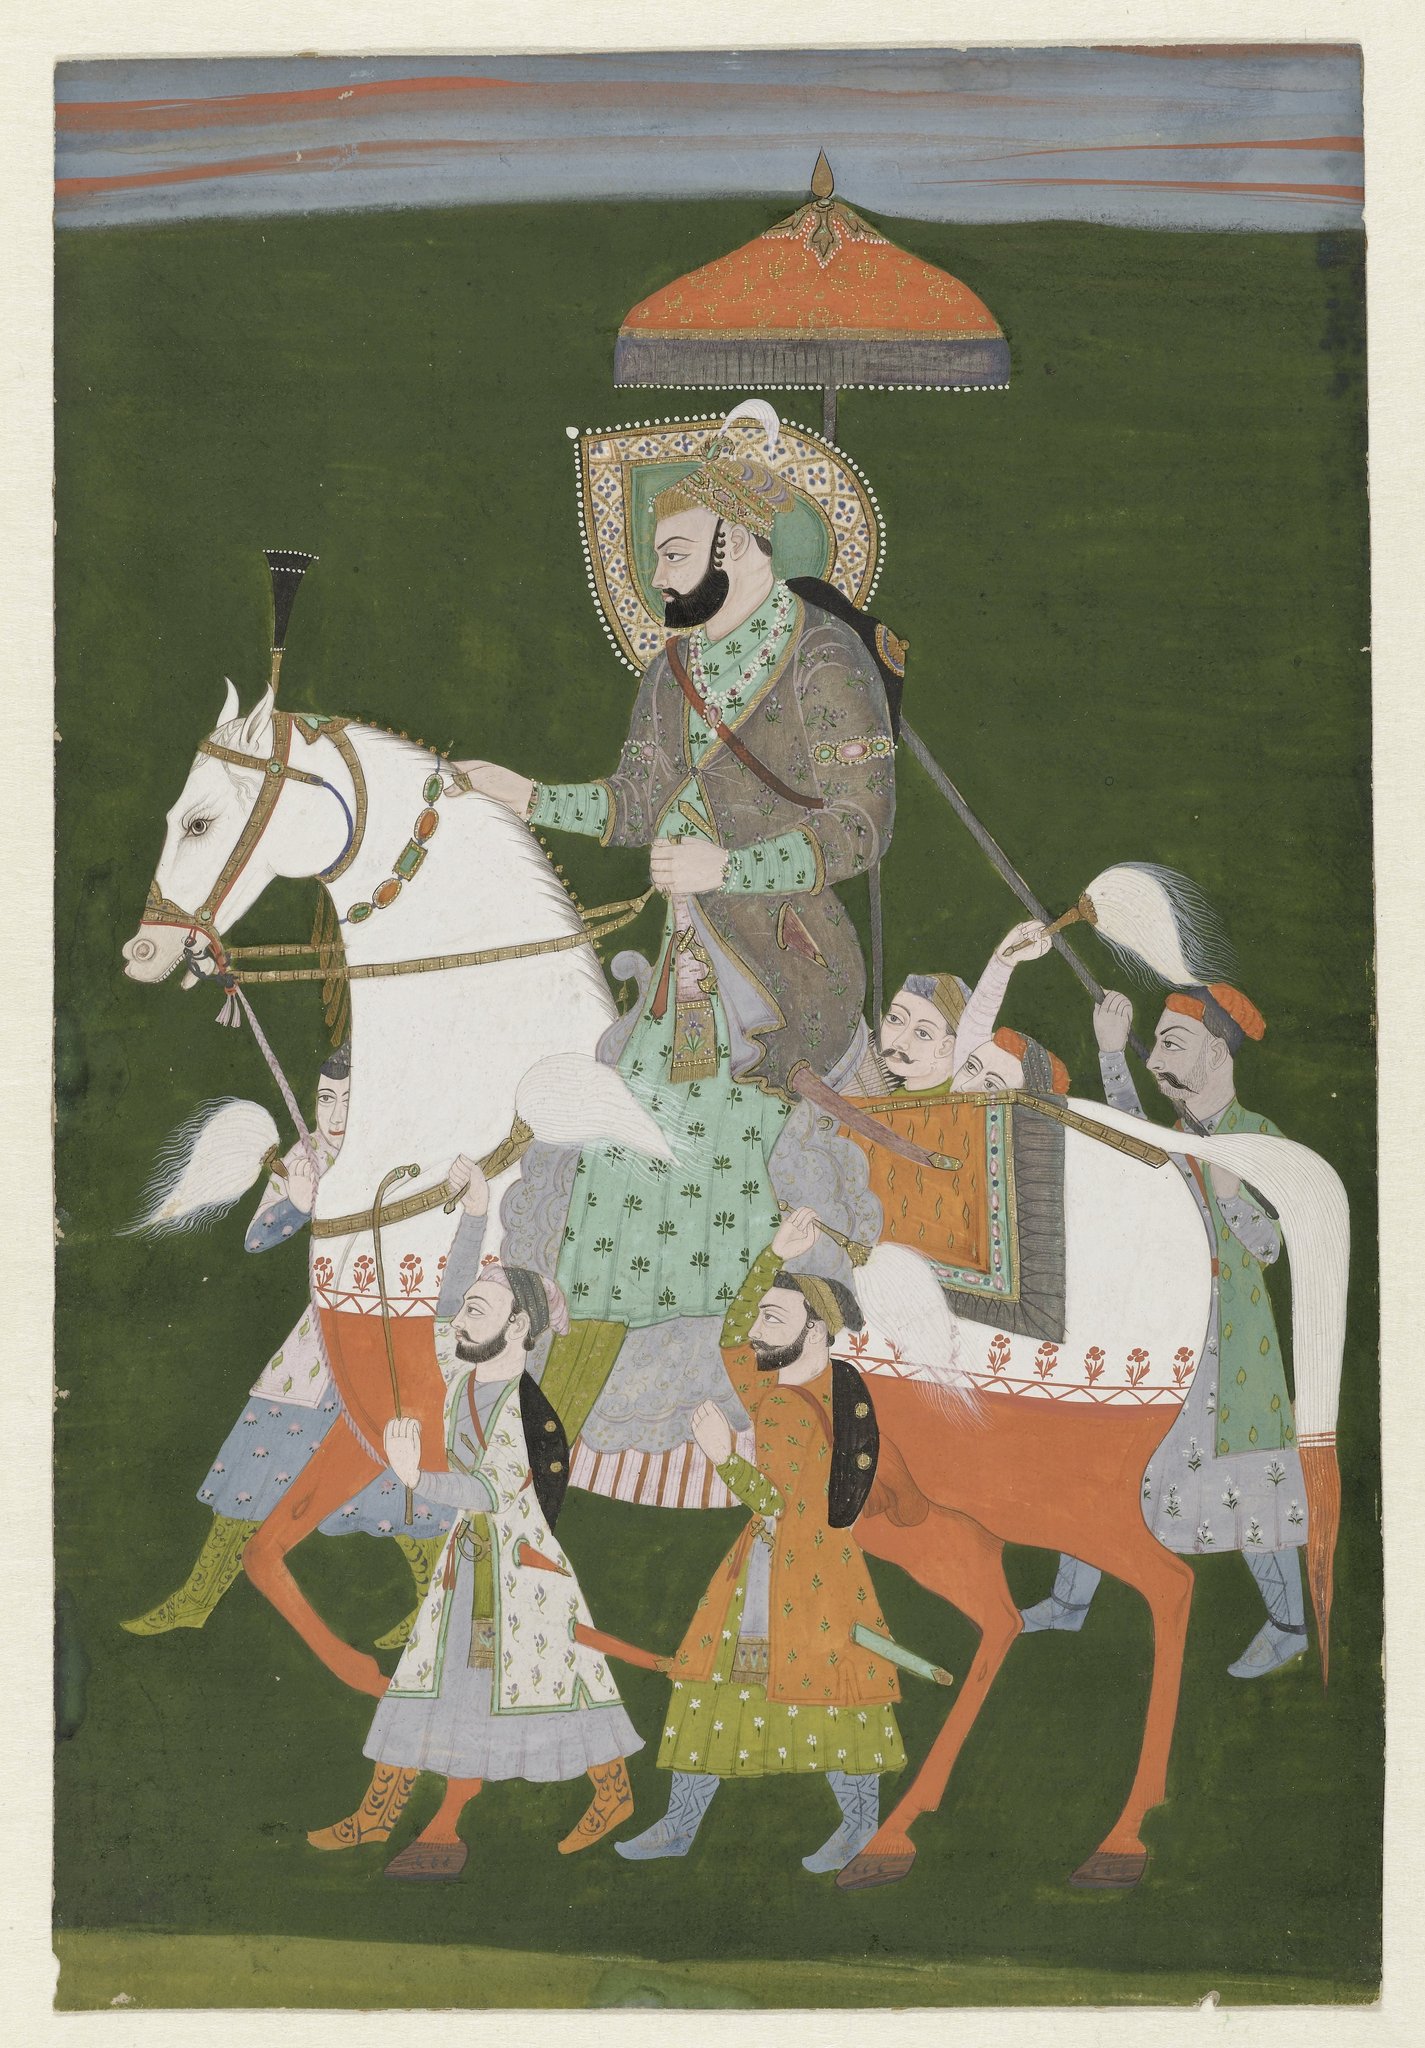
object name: indian miniature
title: Portret van Farruk Siyar te paard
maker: Anonymous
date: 1750-1799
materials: paint, gouache, paper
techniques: brush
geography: deccan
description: Portret van Farruk Siyar (1712-1719) te paard.